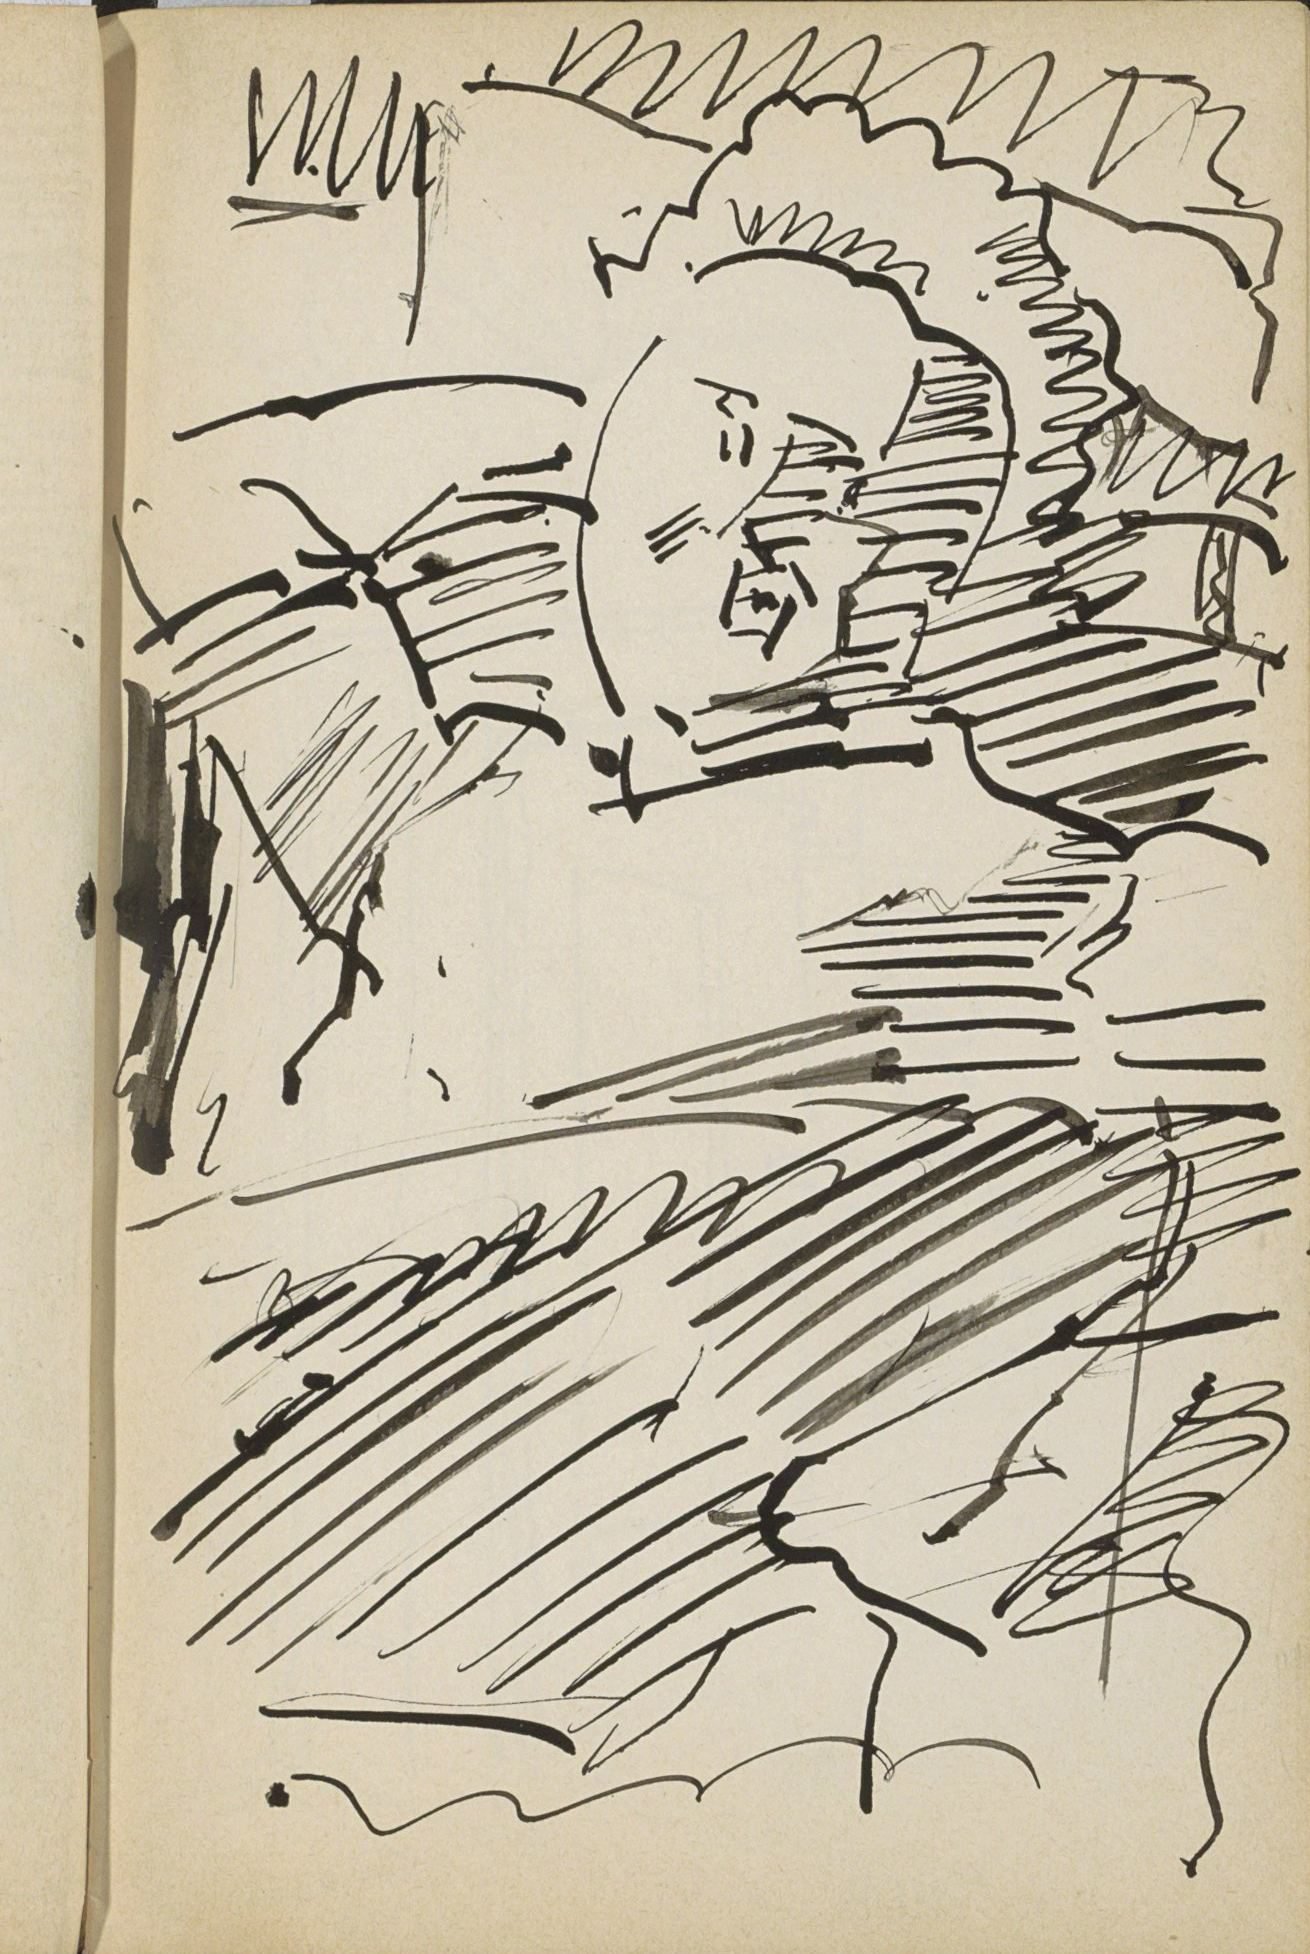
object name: sketchbook leaf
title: Man zittend met zijn hand achter het hoofd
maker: reijer stolk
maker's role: draughtsman, print maker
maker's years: 1896-1945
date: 1908-1919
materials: ink, paper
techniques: pen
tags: sitting figure, hand behind the head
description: Blad 26 recto uit een schetsboek met 33 bladen.